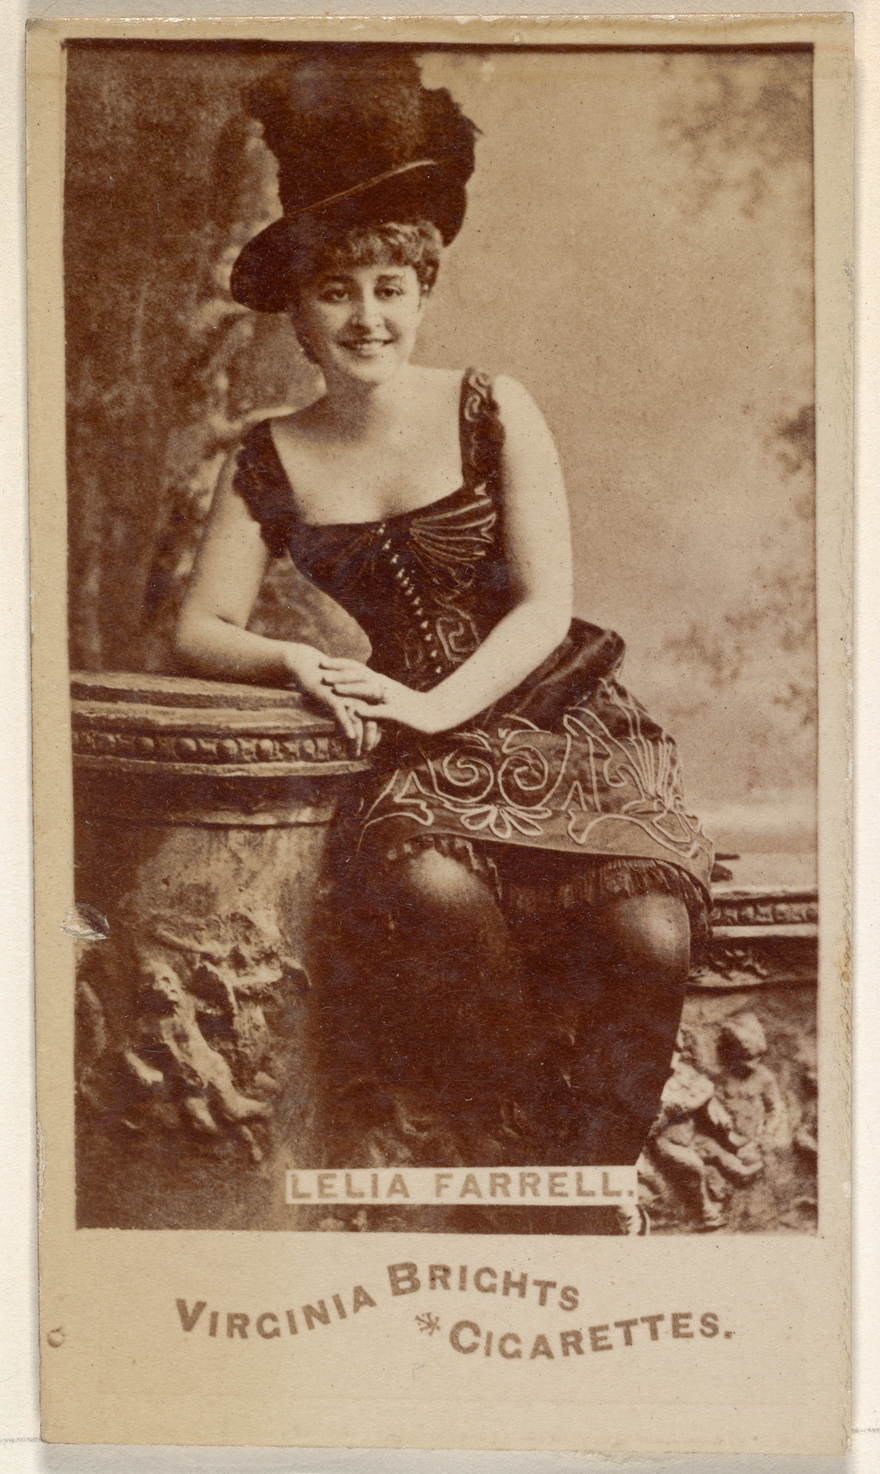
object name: photograph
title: Lelia Farrell, from the Actors and Actresses series (N45, Type 6) for Virginia Brights Cigarettes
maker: allen & ginter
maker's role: publisher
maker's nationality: american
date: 1888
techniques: albumen silver print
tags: portraits,women,actresses